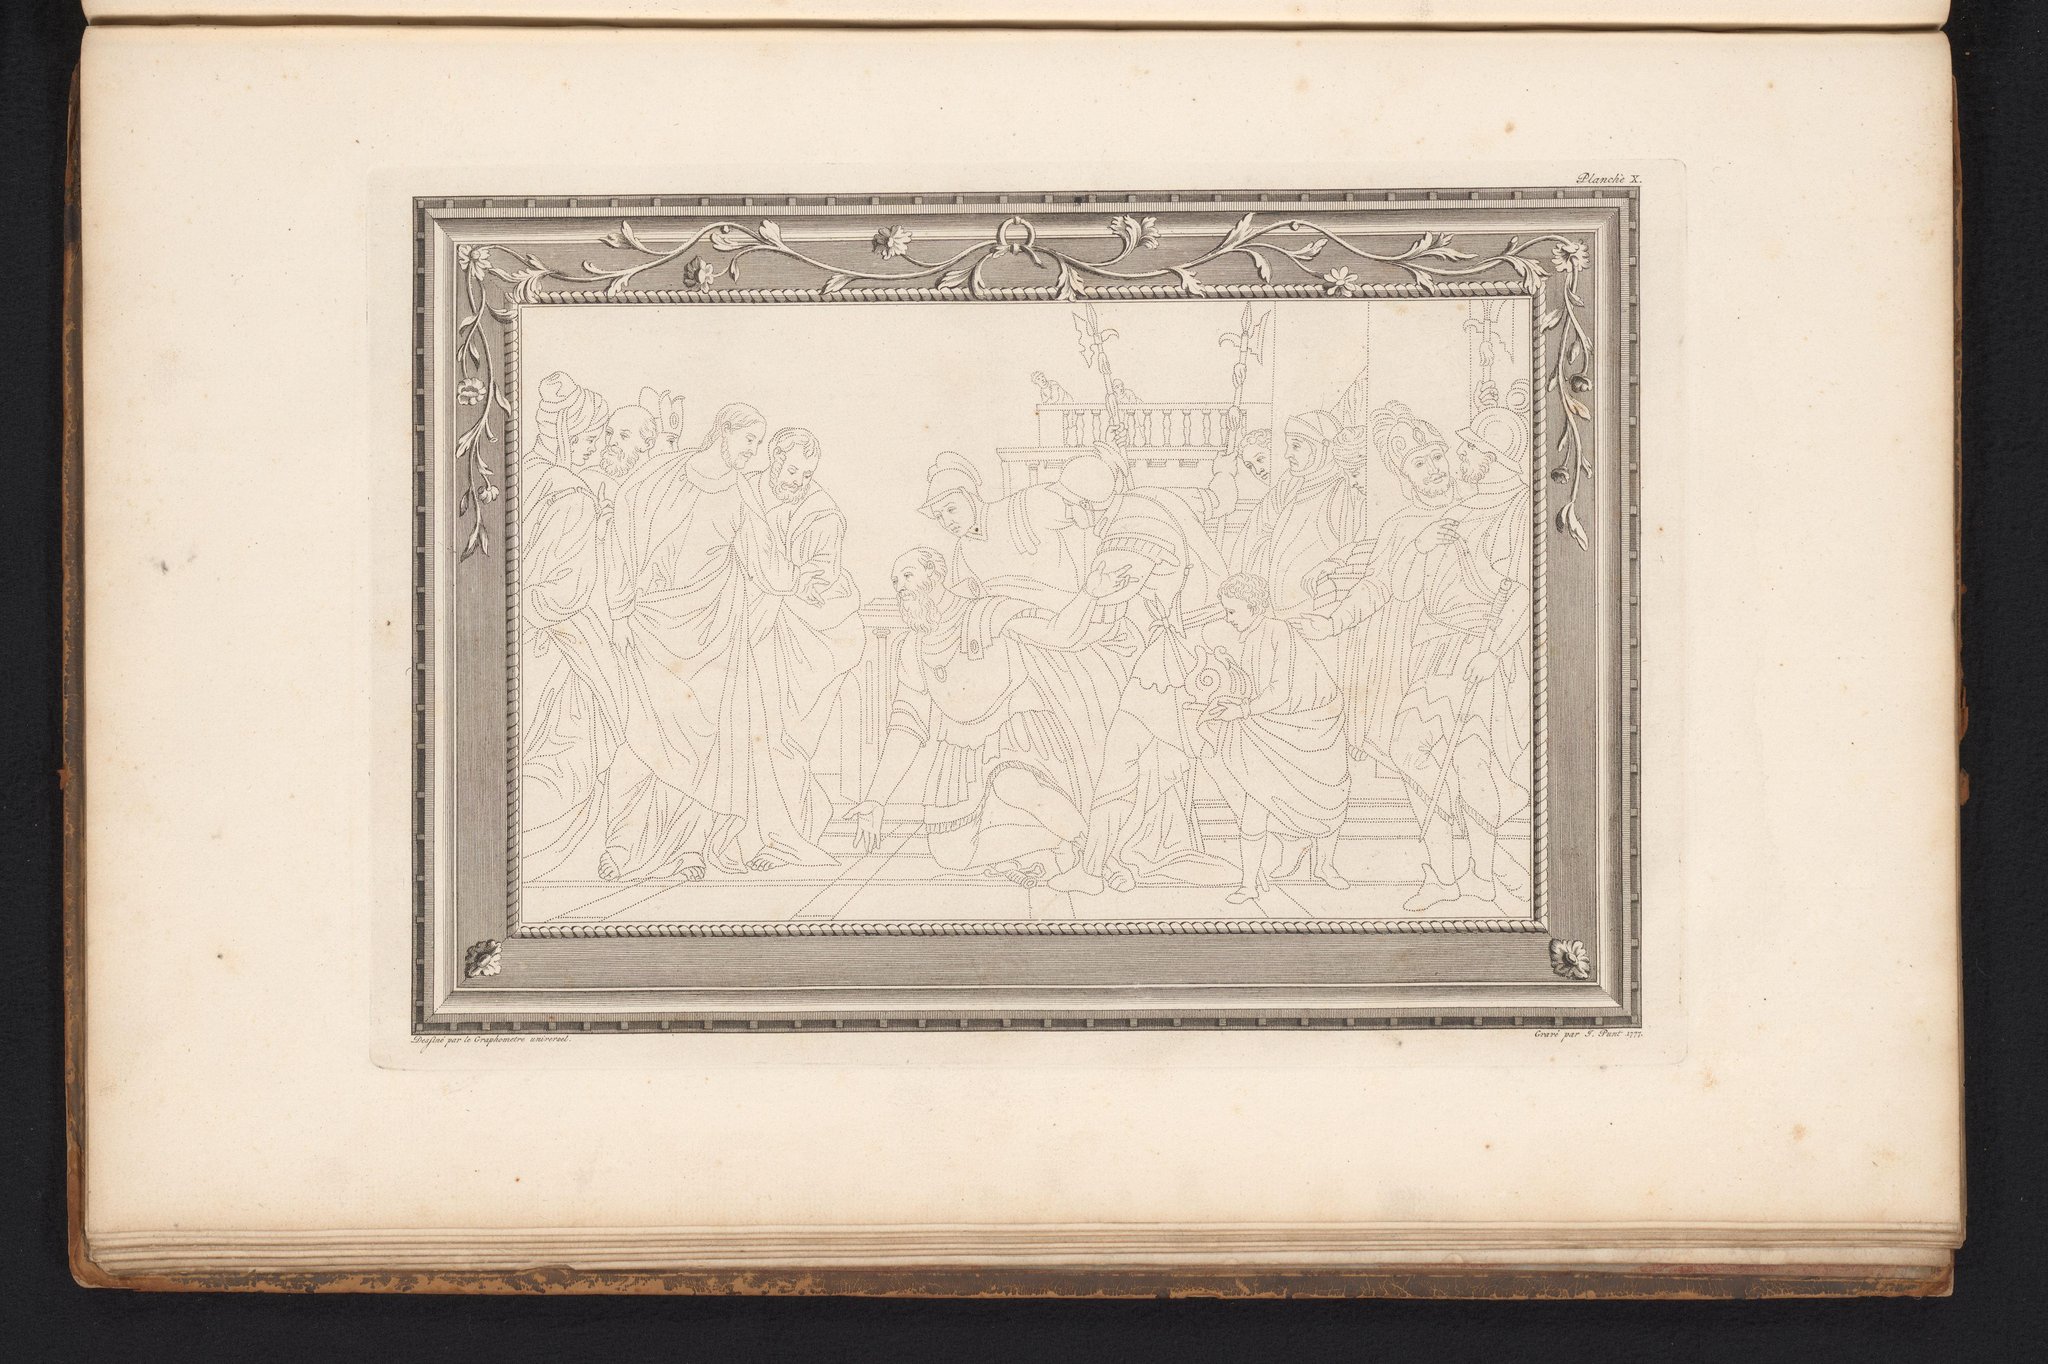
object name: album leaf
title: Hoofdman van Kafarnaüm smeekt Christus om hulp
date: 1777-1778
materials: paper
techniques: engraving, etching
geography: amsterdam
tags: instruments for perspective drawing, the centurion of capernaum, kneeling before christ, begs him to heal his paralytic servant (or son) (matthew 8:5-13; luke 7:1-10; john 4:46-54)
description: Een afbeelding van een lijst met een schilderij over de hoofdman van Kafarnaüm die Christus om hulp smeekt. Het schilderij is in omtrek getekend met behulp van een grafometer. In Kafarnaüm knielt een Romeinse centurio, omringd door zijn soldaten, voor Christus. Hij vraagt hem zijn knecht te genezen. Hij heeft zijn helm afgenomen voor Christus, een schildknaap houdt hem vast. Christus stuurt de centurio naar huis en geneest tegelijkertijd diens knecht. Rechtsboven gemerkt: Planche X. De prent maakt deel uit van het boek: A.G. Eckhardt, Beschryving van een algemeenen graphometer, 1778.